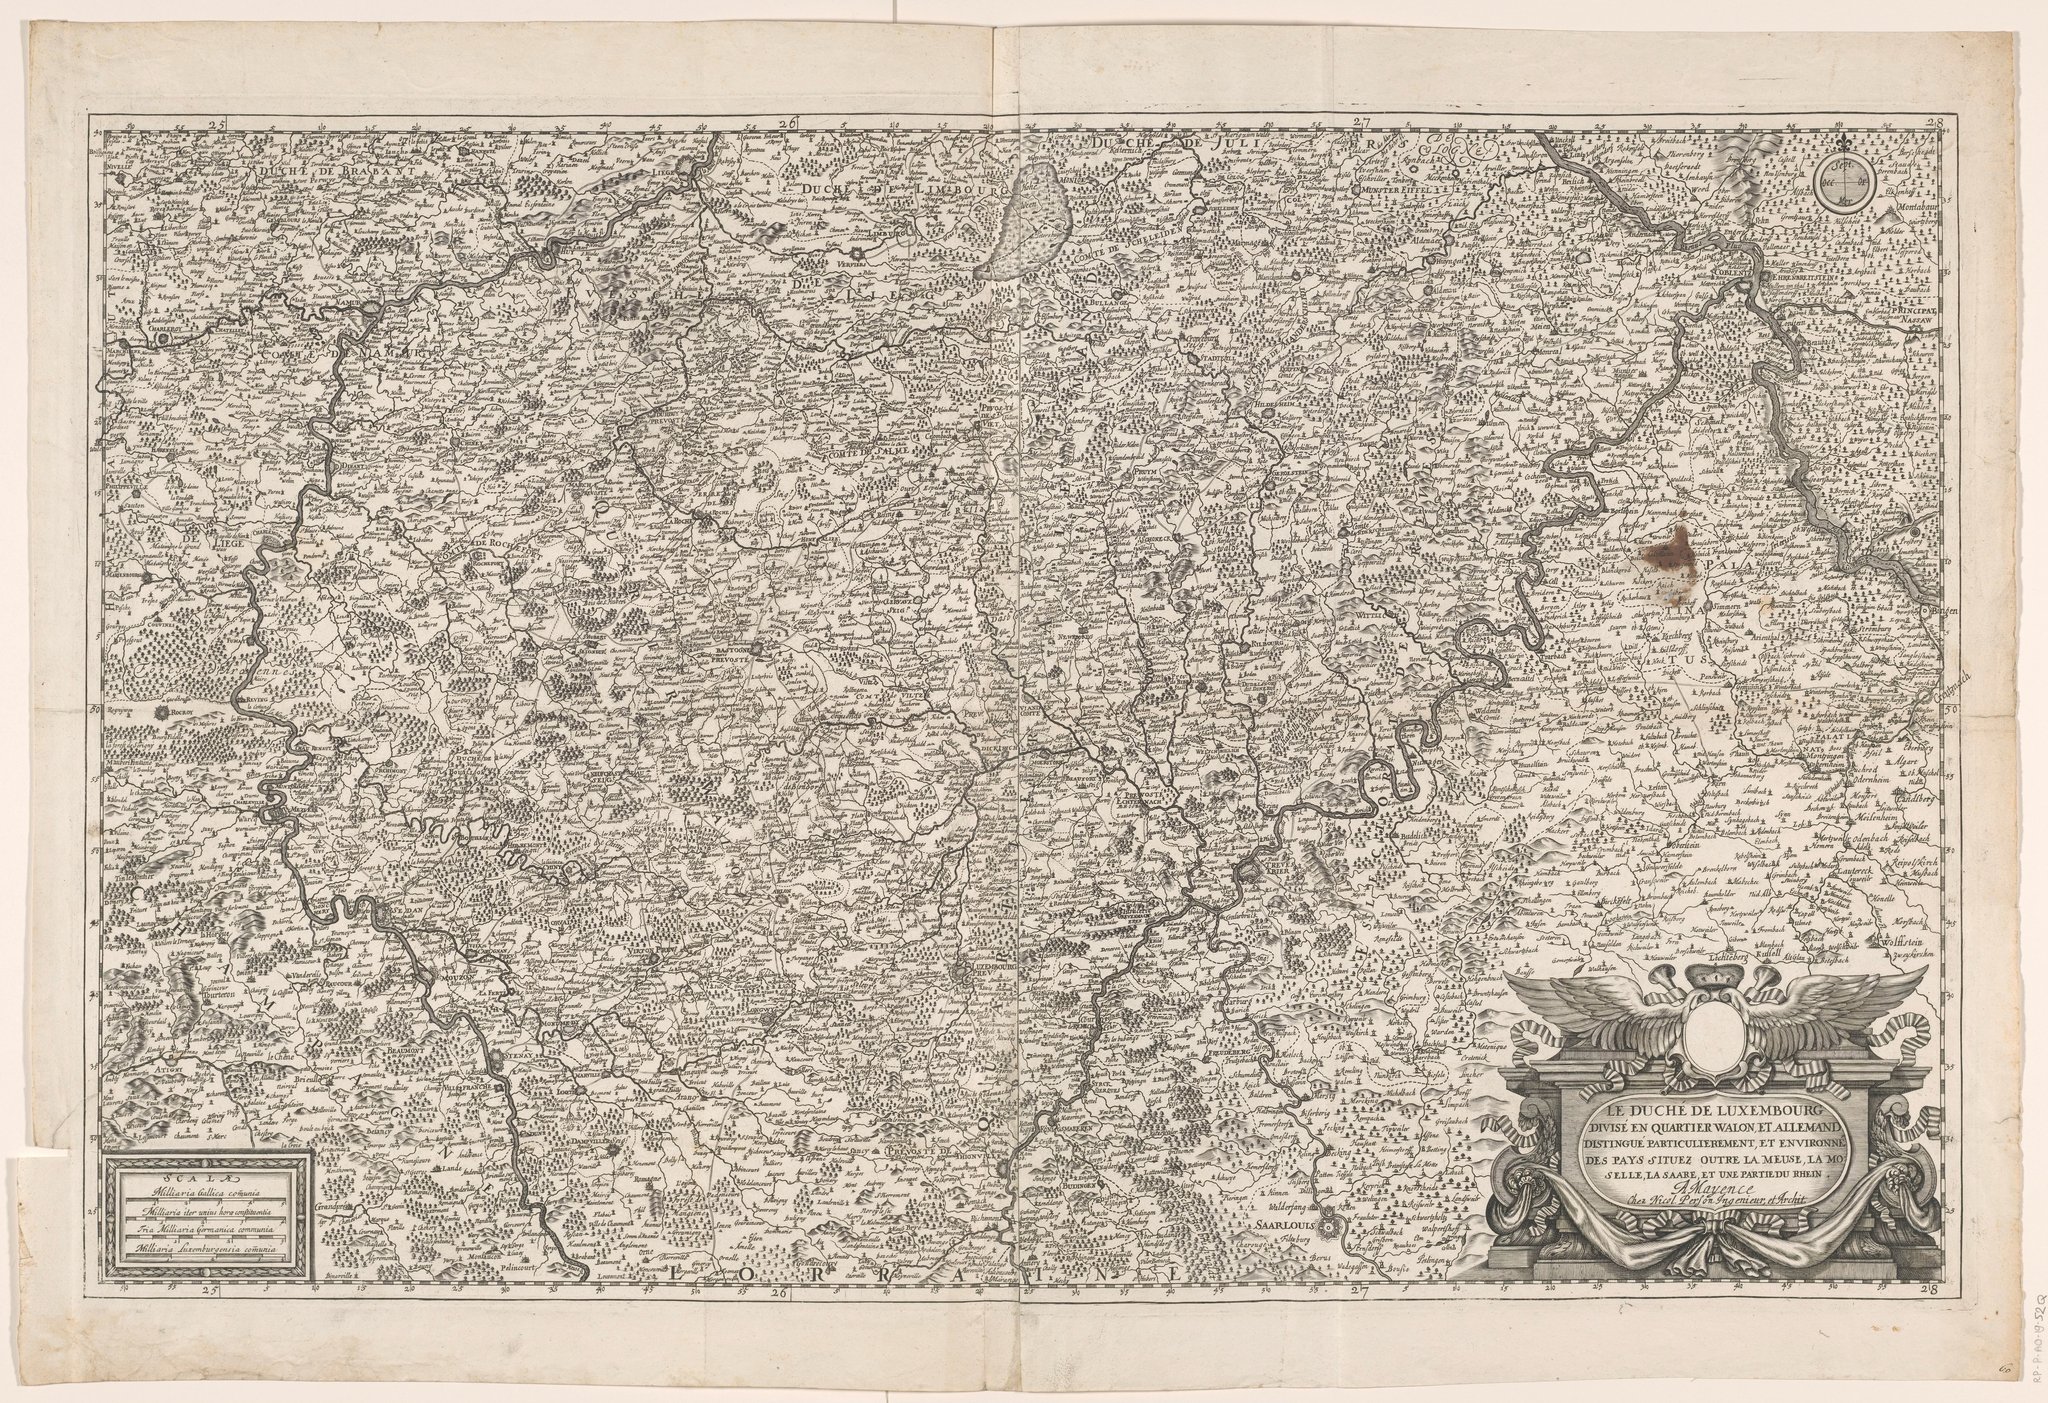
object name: map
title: Le duché de Luxembourg divisé en quartier Walon, et Allemand (...)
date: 1668-1710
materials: paper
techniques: engraving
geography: mainz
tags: maps of separate countries or regions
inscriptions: collector's mark: Lugt 2228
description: Kaart van Luxemburg. Rechtsonder de titelcartouche. Linksonder een cartouche met vier schaalstokken: 5 Milliaria Gallica comunia / 4 Milliaria iter unius horae constituentia. De kaart is voorzien van een gradenverdeling langs de randen.